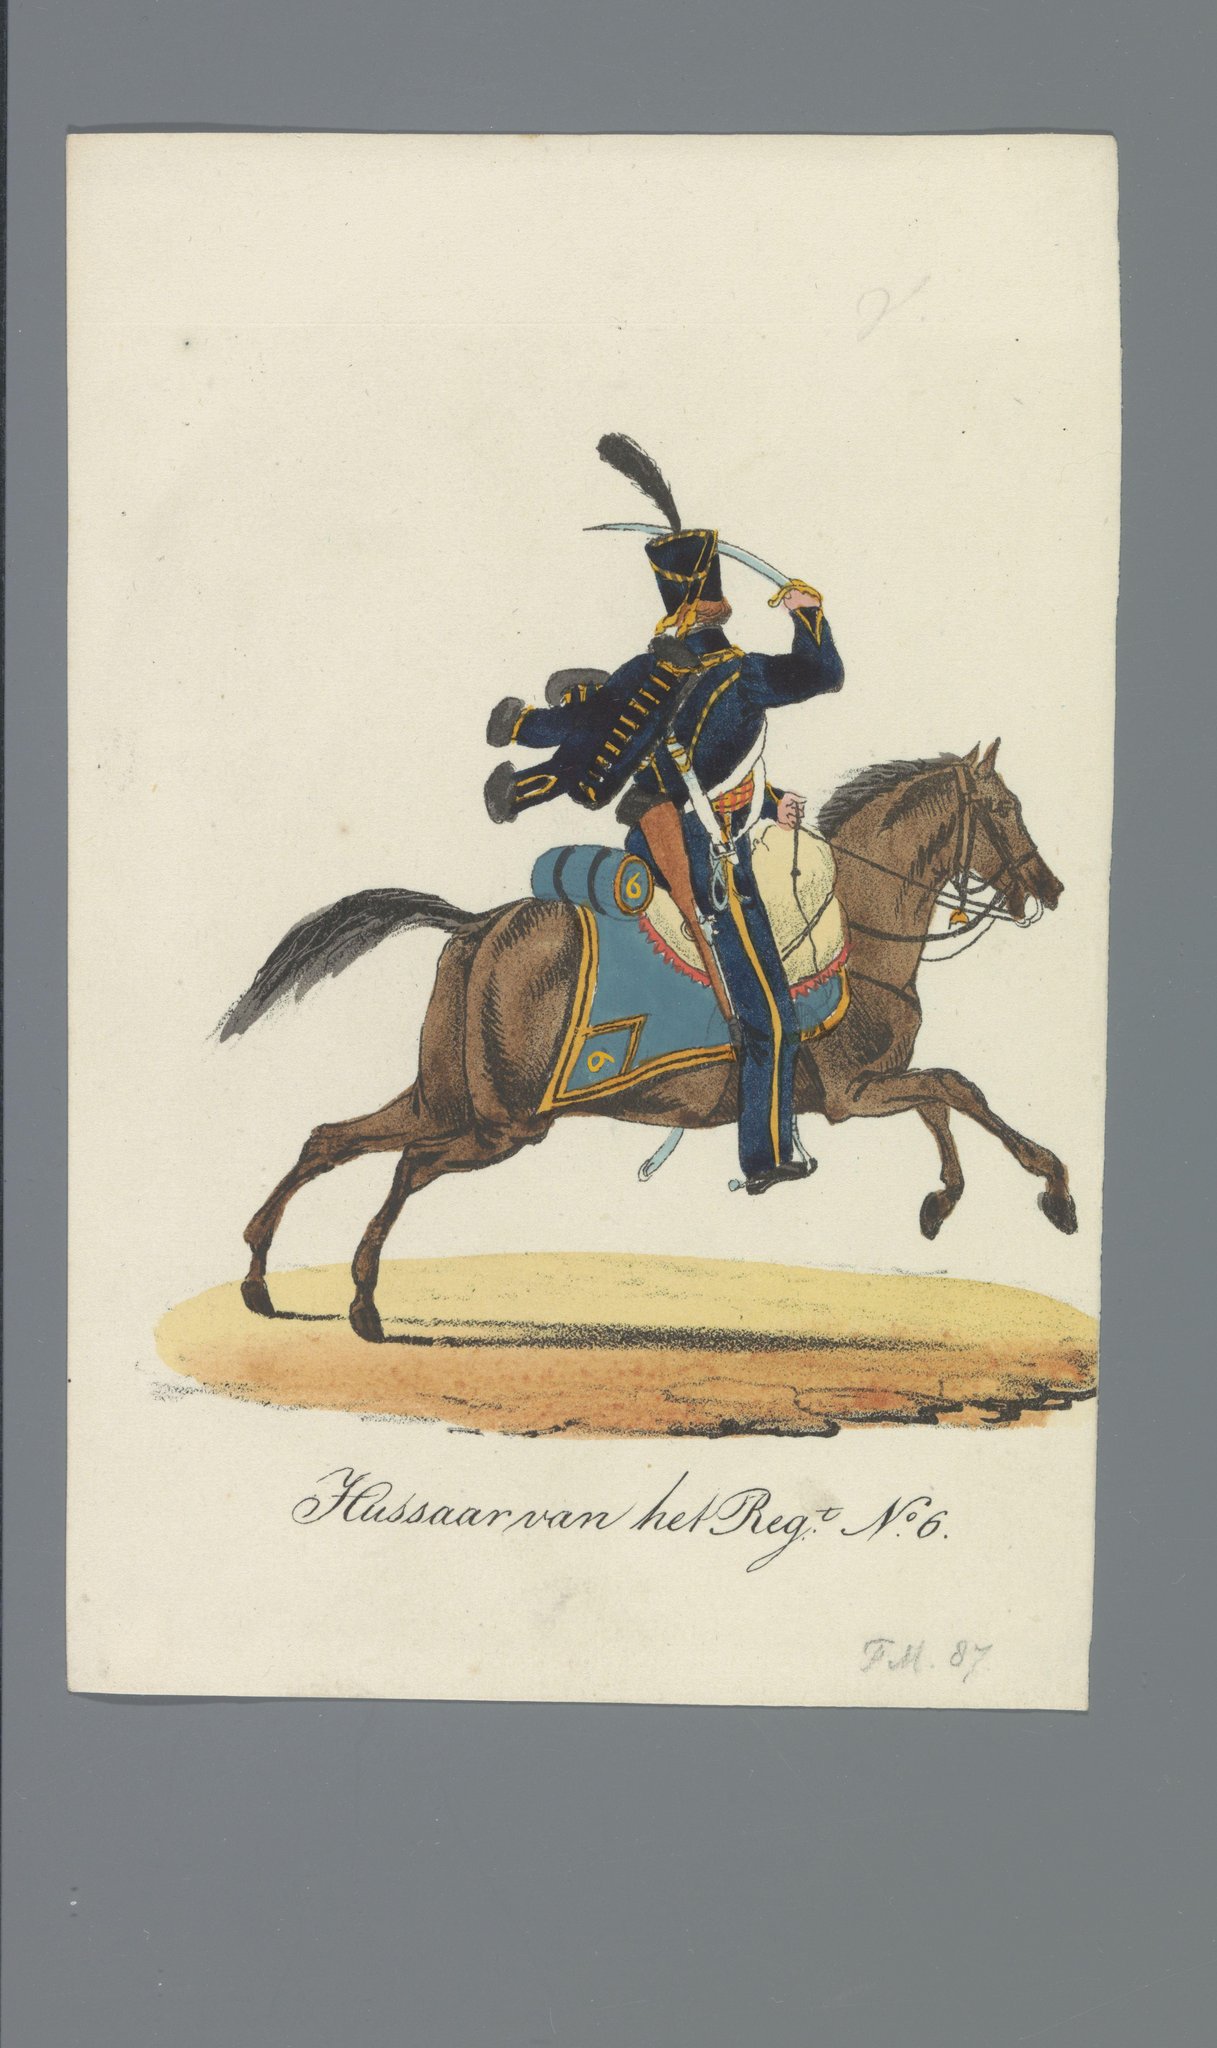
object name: print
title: Hussaar van het Reg.t No. 6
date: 1835-1850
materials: paper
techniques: hand coloring, lithograph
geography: utrecht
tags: (military) uniforms, clothes, costume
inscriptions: collector's mark: Lugt 2228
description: Een huzaar van het Regiment Huzaren Nr 6, te paard. Onderdeel van een serie van 157 losse bladen met Nederlandse militaire uniformen in de jaren 1830-1832.